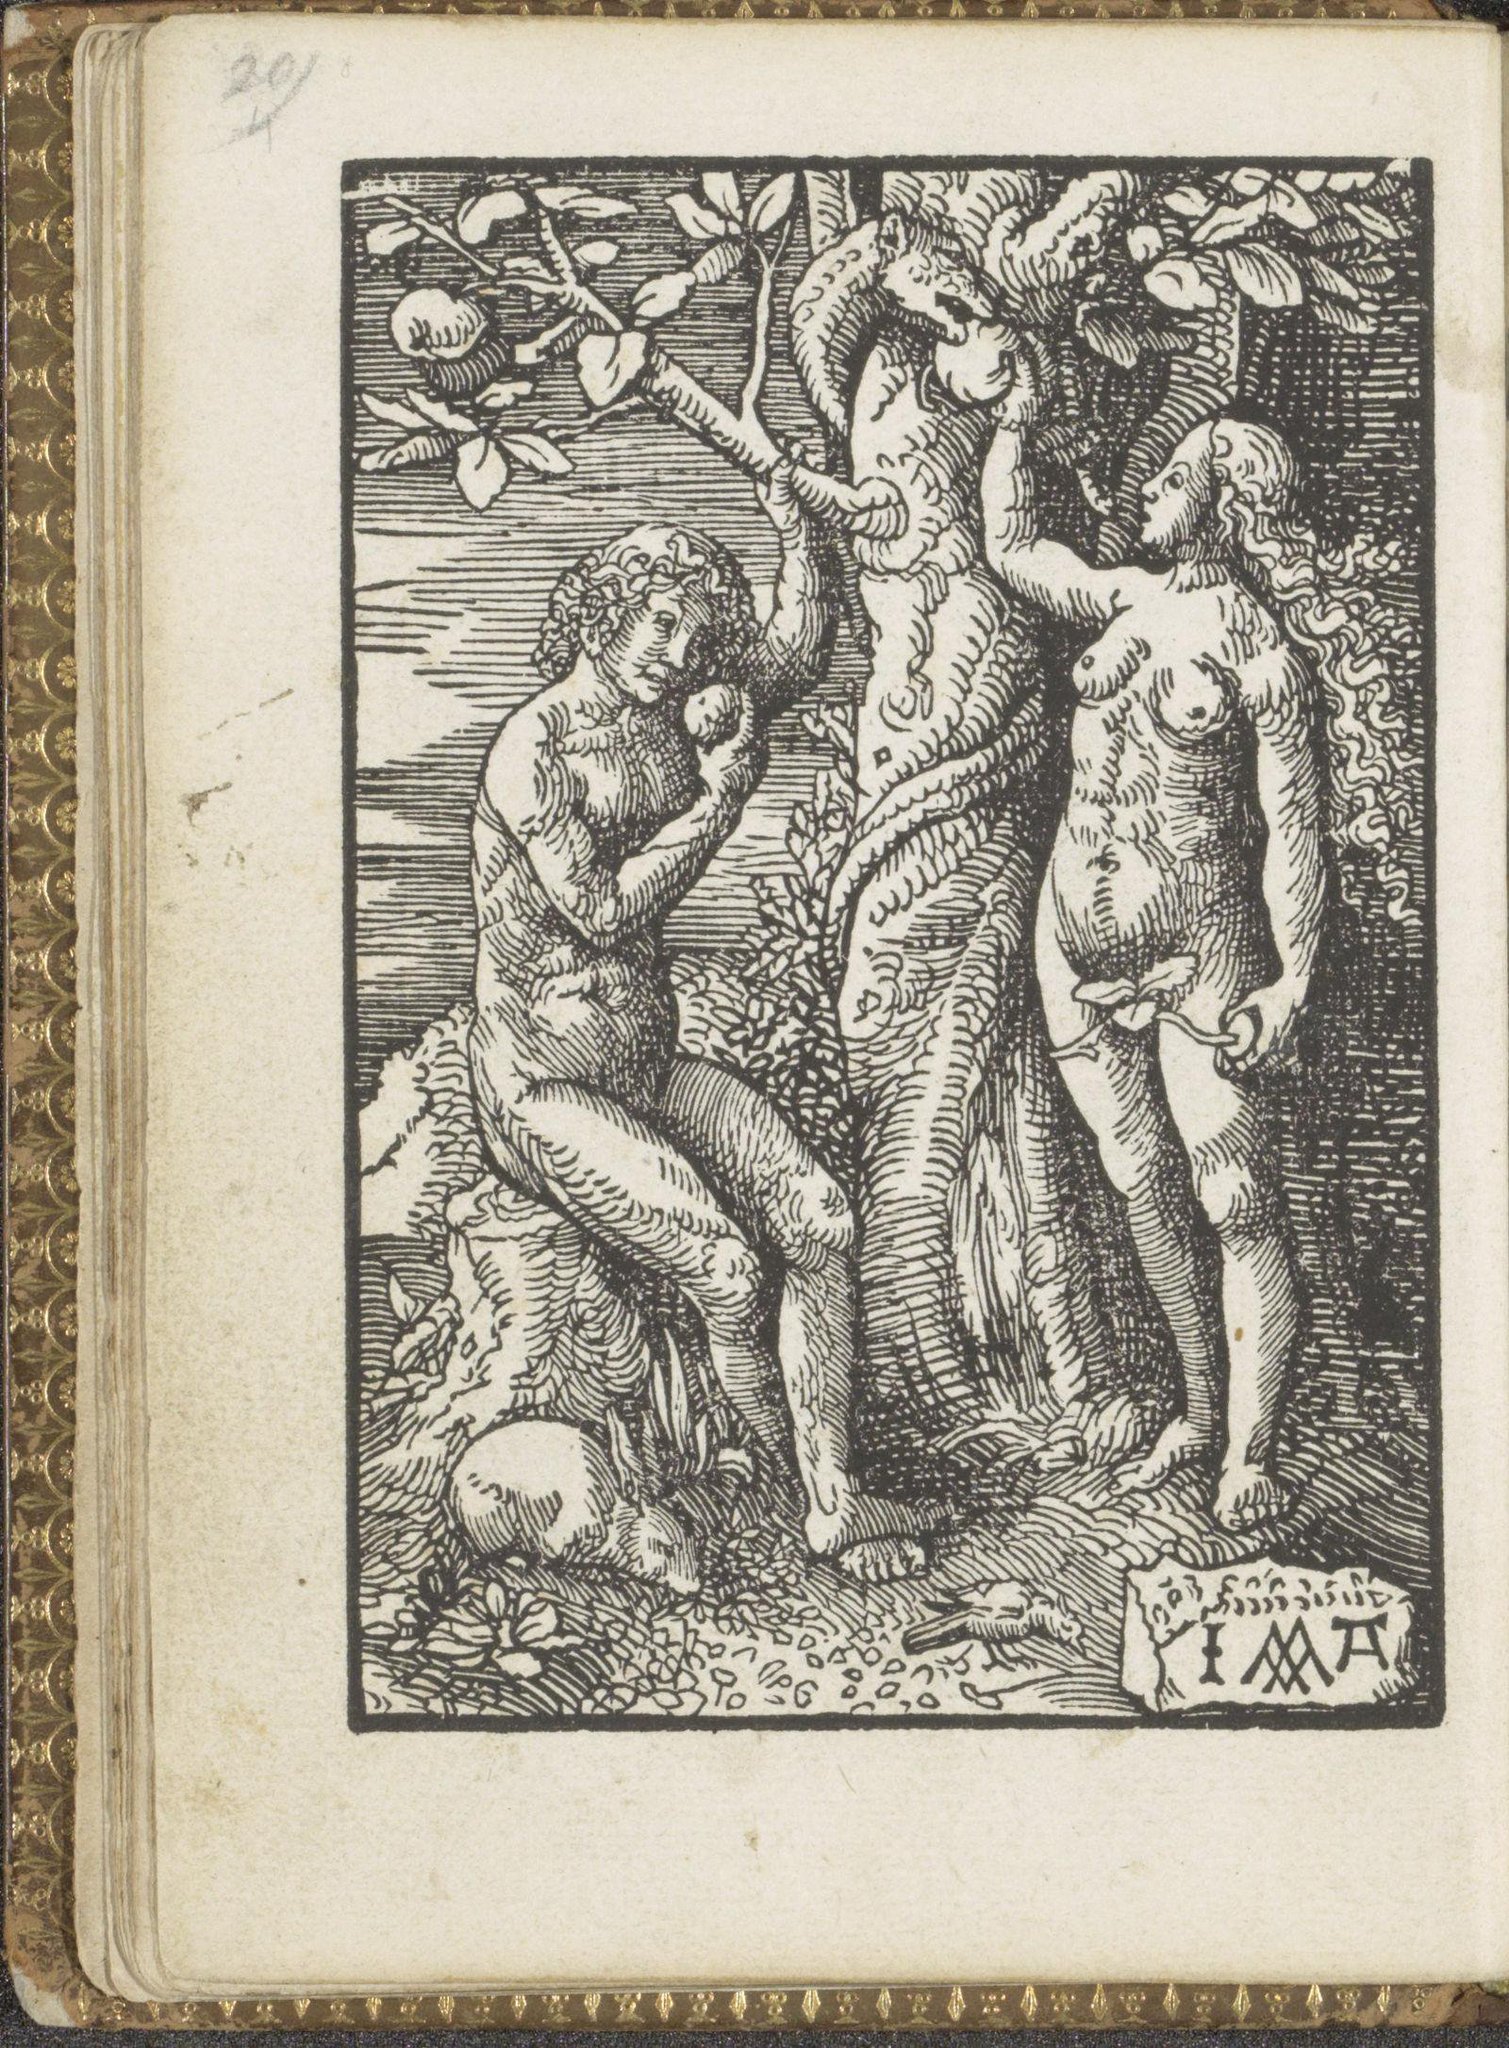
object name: print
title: De kleine Passie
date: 1523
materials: paper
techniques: woodcut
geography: amsterdam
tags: adam and eve holding (and possibly eating) the fruit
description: Adam en Eva staan bij de boom van goed en kwaad in het paradijs. Adam neemt een hap van een appel, Eva neemt een appel aan van de slang. Op de grond een konijn en een vogel. Prent maakt deel uit van een boek.